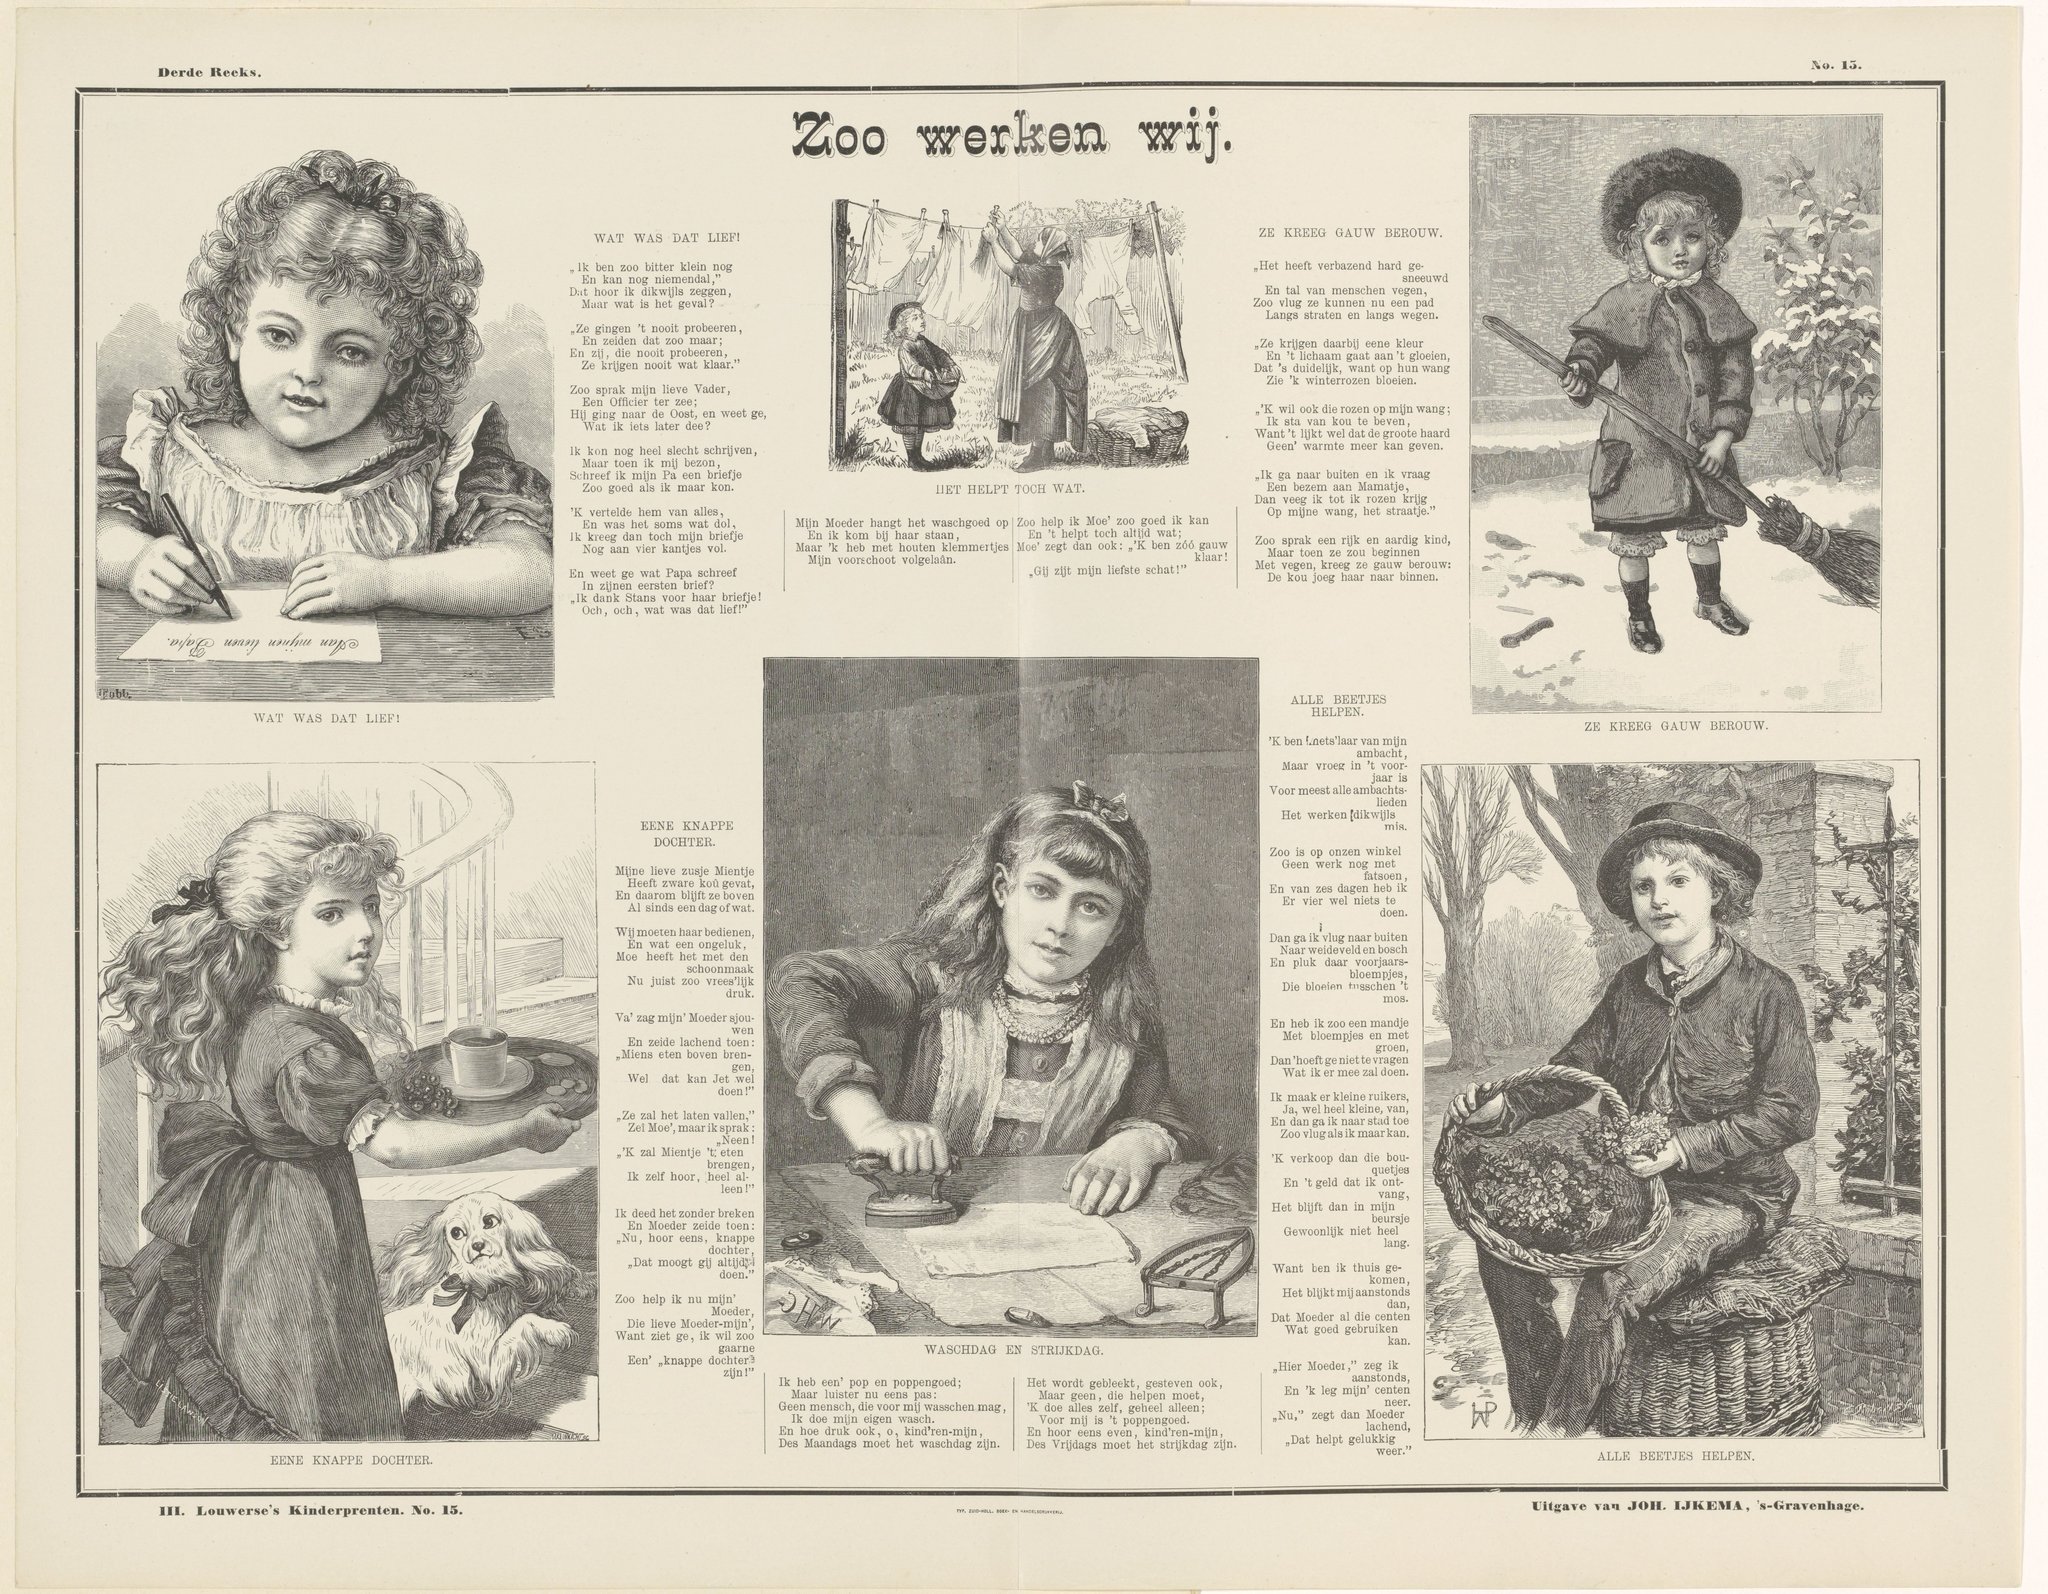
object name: print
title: Zoo werken wij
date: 1892-1905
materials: paper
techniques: letterpress printing, printing block, engraving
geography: the hague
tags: child, household chores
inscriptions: collector's mark: Lugt 2760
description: Blad met 6 voorstellingen van bezigheden en klusjes voor kinderen, zoals studeren, strijken en de was ophangen. Tussen de afbeeldingen versjes in boekdruk. Genummerd rechtsboven en linksonder: No. 15.